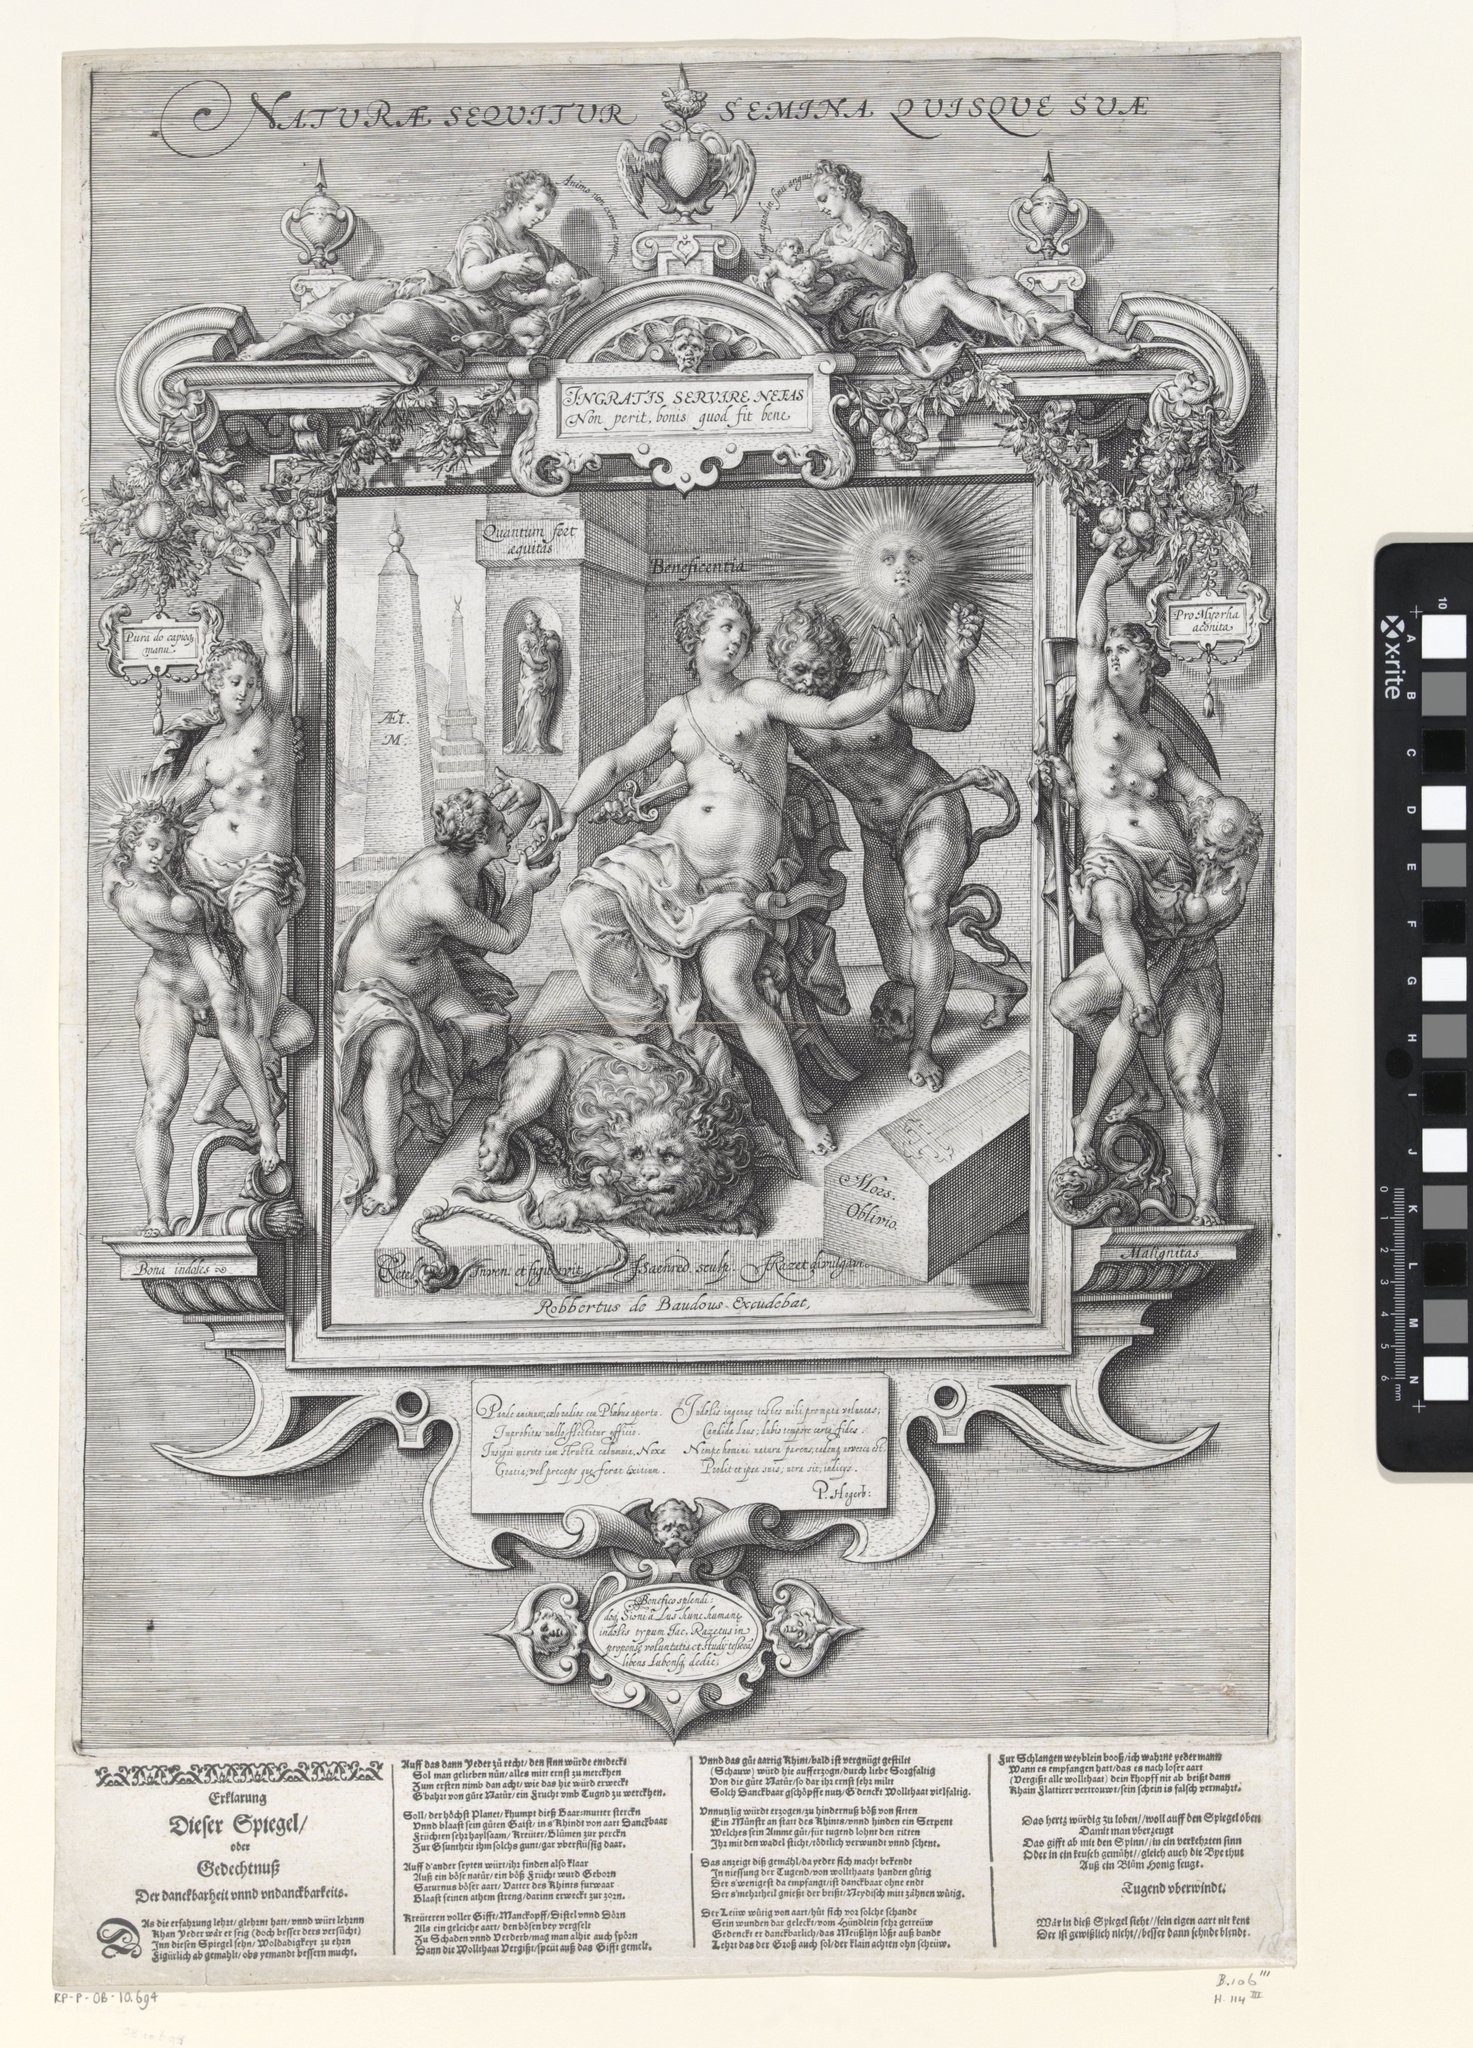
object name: print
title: Allegorie op de menselijke aard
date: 1610-1648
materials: paper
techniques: engraving, letterpress printing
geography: northern netherlands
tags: fertility, good, right, bad, evil, wrong, (story of) apollo (phoebus), nursing, suckling, sun as celestial body, beasts of prey, predatory animals: lion, moon as celestial body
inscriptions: collector's mark: Lugt 240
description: Beneficentia, de personificatie van weldadigheid, zit op een stoel en wordt van achteren neergestoken door het kwaad in de gedaante van een naakte man. Een knie van de man leunt op een schedel en een slang, die in zijn eigen staart bijt als symbool van eeuwigheid, hangt rond zijn rechterbeen. Rechts staat een doodskist met het opschrift: Mors Oblivio. Met haar linkerhand geeft Beneficentia de zon aan de naakte man. De maan geeft ze aan de vrouw voor haar. Tussen hen in ligt een vastgebonden leeuw, die aan een hond likt. Een muis knaagt aan zijn touw. Op de achtergrond enkele obelisken. De voorstelling heeft een ornamentele omlijsting. Links baart de personificatie van de vruchtbaarheid een kind, dat door de adem van Apollo als symbool van het goede tot leven wordt gewekt. Rechts wordt een kind gebaard dat zijn adem van het Kwaad ontvangt. Linksboven geeft een vrouw een kind de borst. Rechtsboven voedt een vrouw een kind met een lepel. Onder de voorstelling een achtregelige, Latijnse tekst en een cartouche met een vijfregelige, Latijnse tekst. Daaronder een Duitse tekst.